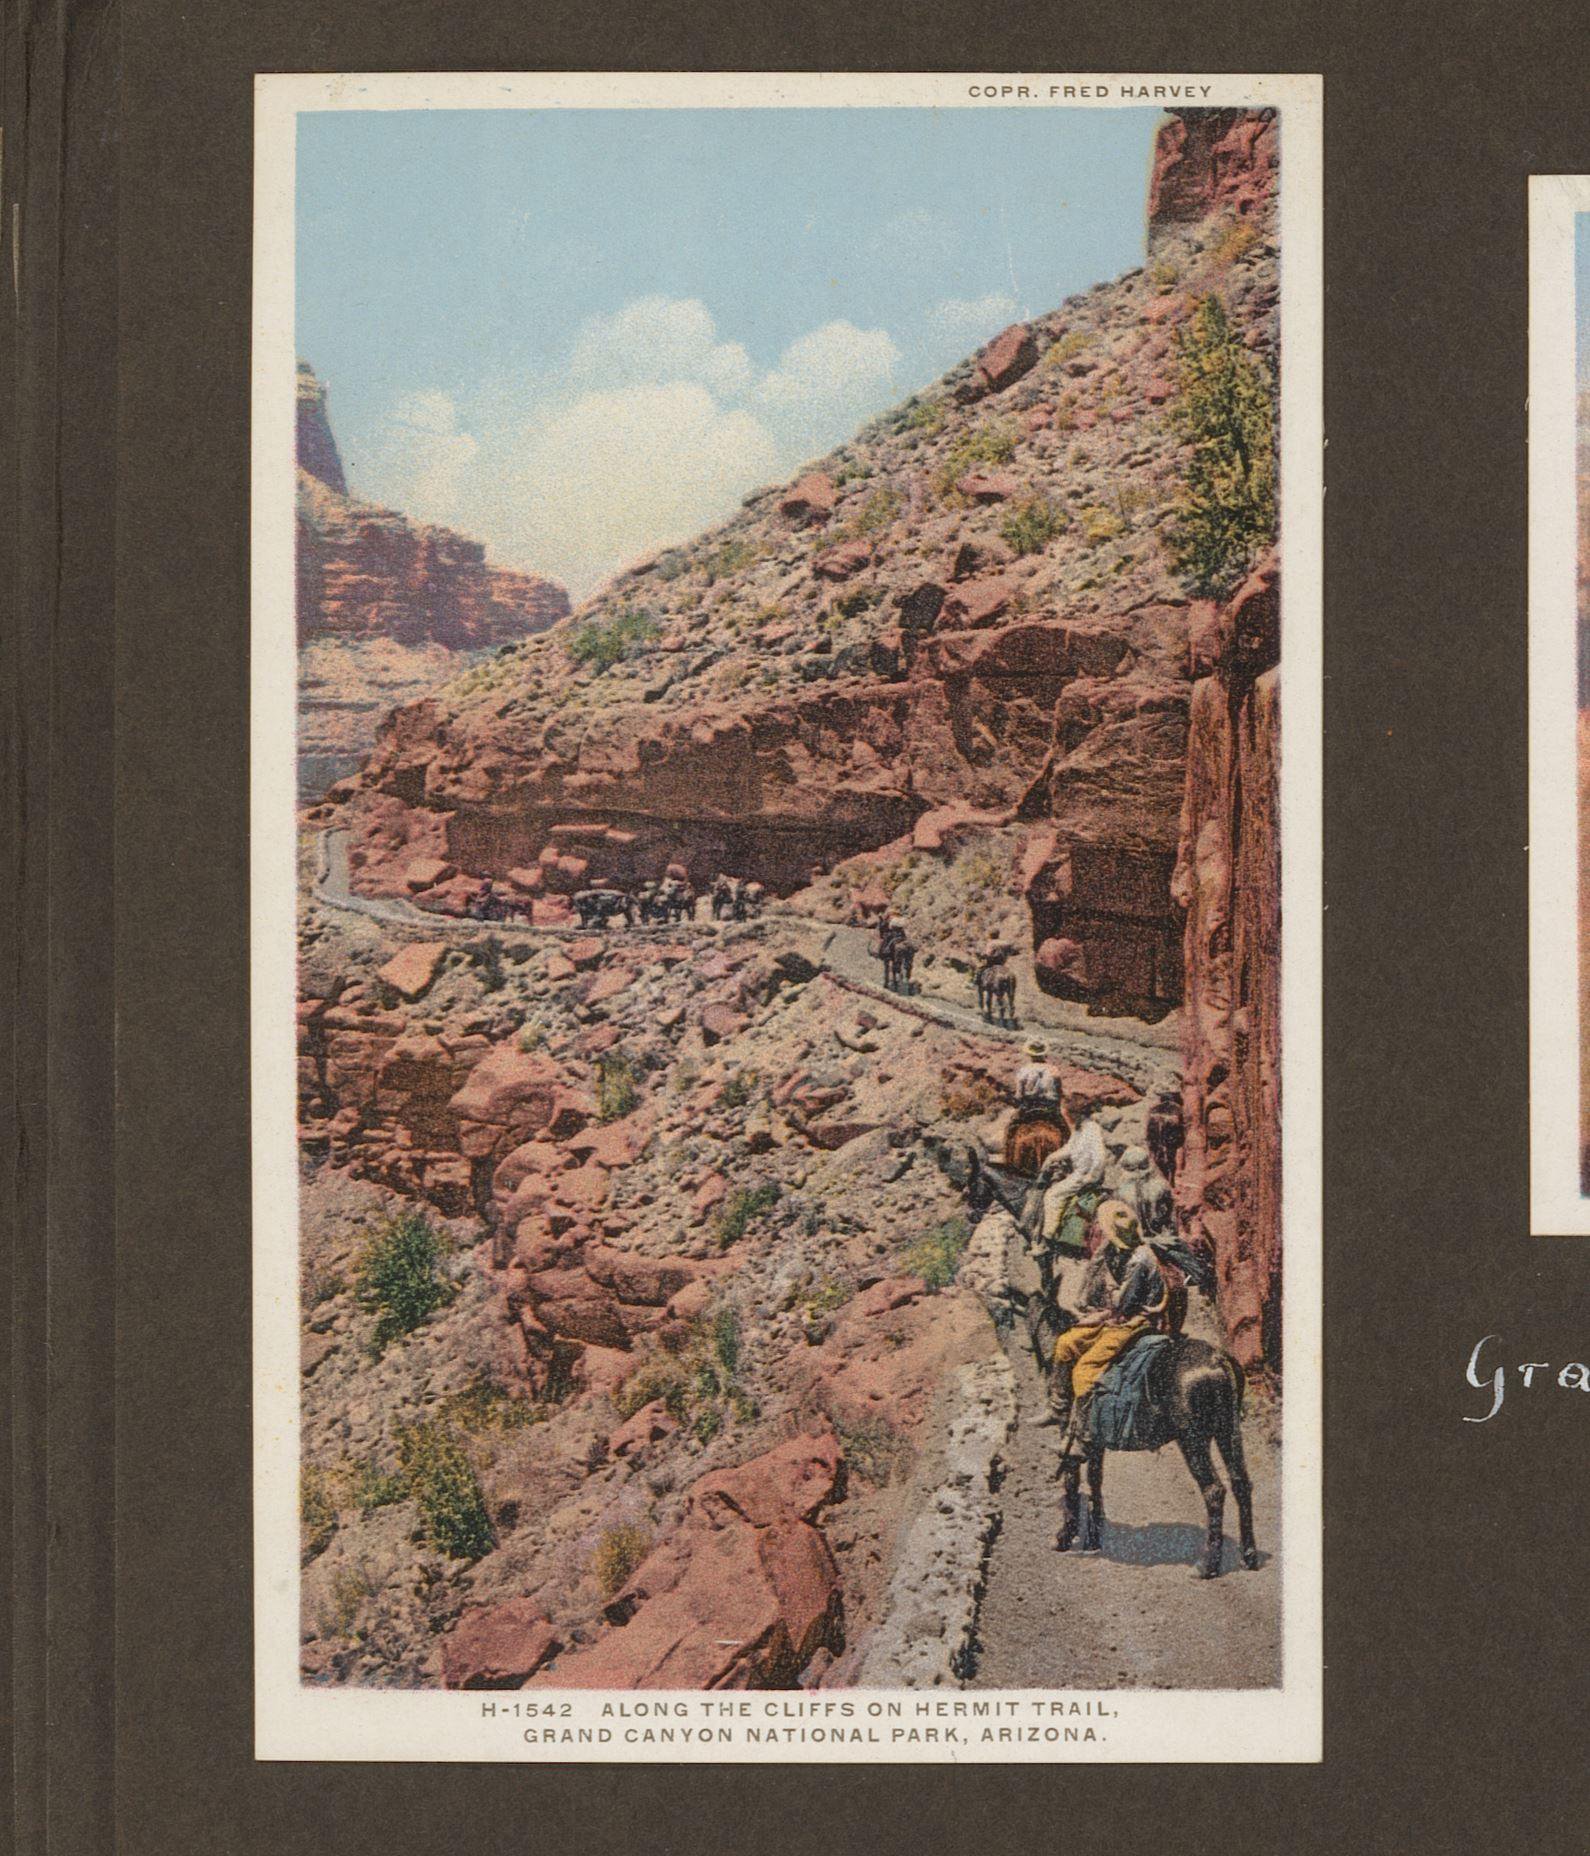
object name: album leaf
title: Along the cliffs on Hermit Trail, Grand Canyon National Park, Arizona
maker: Anonymous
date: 1928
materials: paper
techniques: chromolithography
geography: grand canyon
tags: shop, store, riding a horse, ass, or mule; rider, horseman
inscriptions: number: ‘H-1542’, annotation: ‘Grand Canyon’